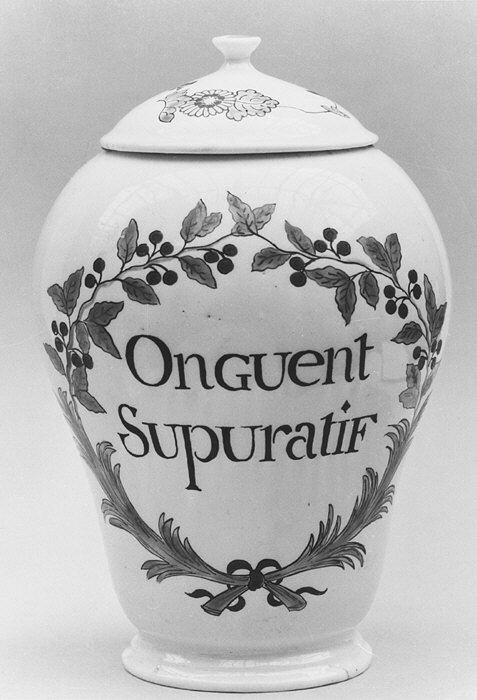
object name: pharmacy jar with cover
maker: chantilly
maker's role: factory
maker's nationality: french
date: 1745-1750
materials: soft paste porcelain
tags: fruit